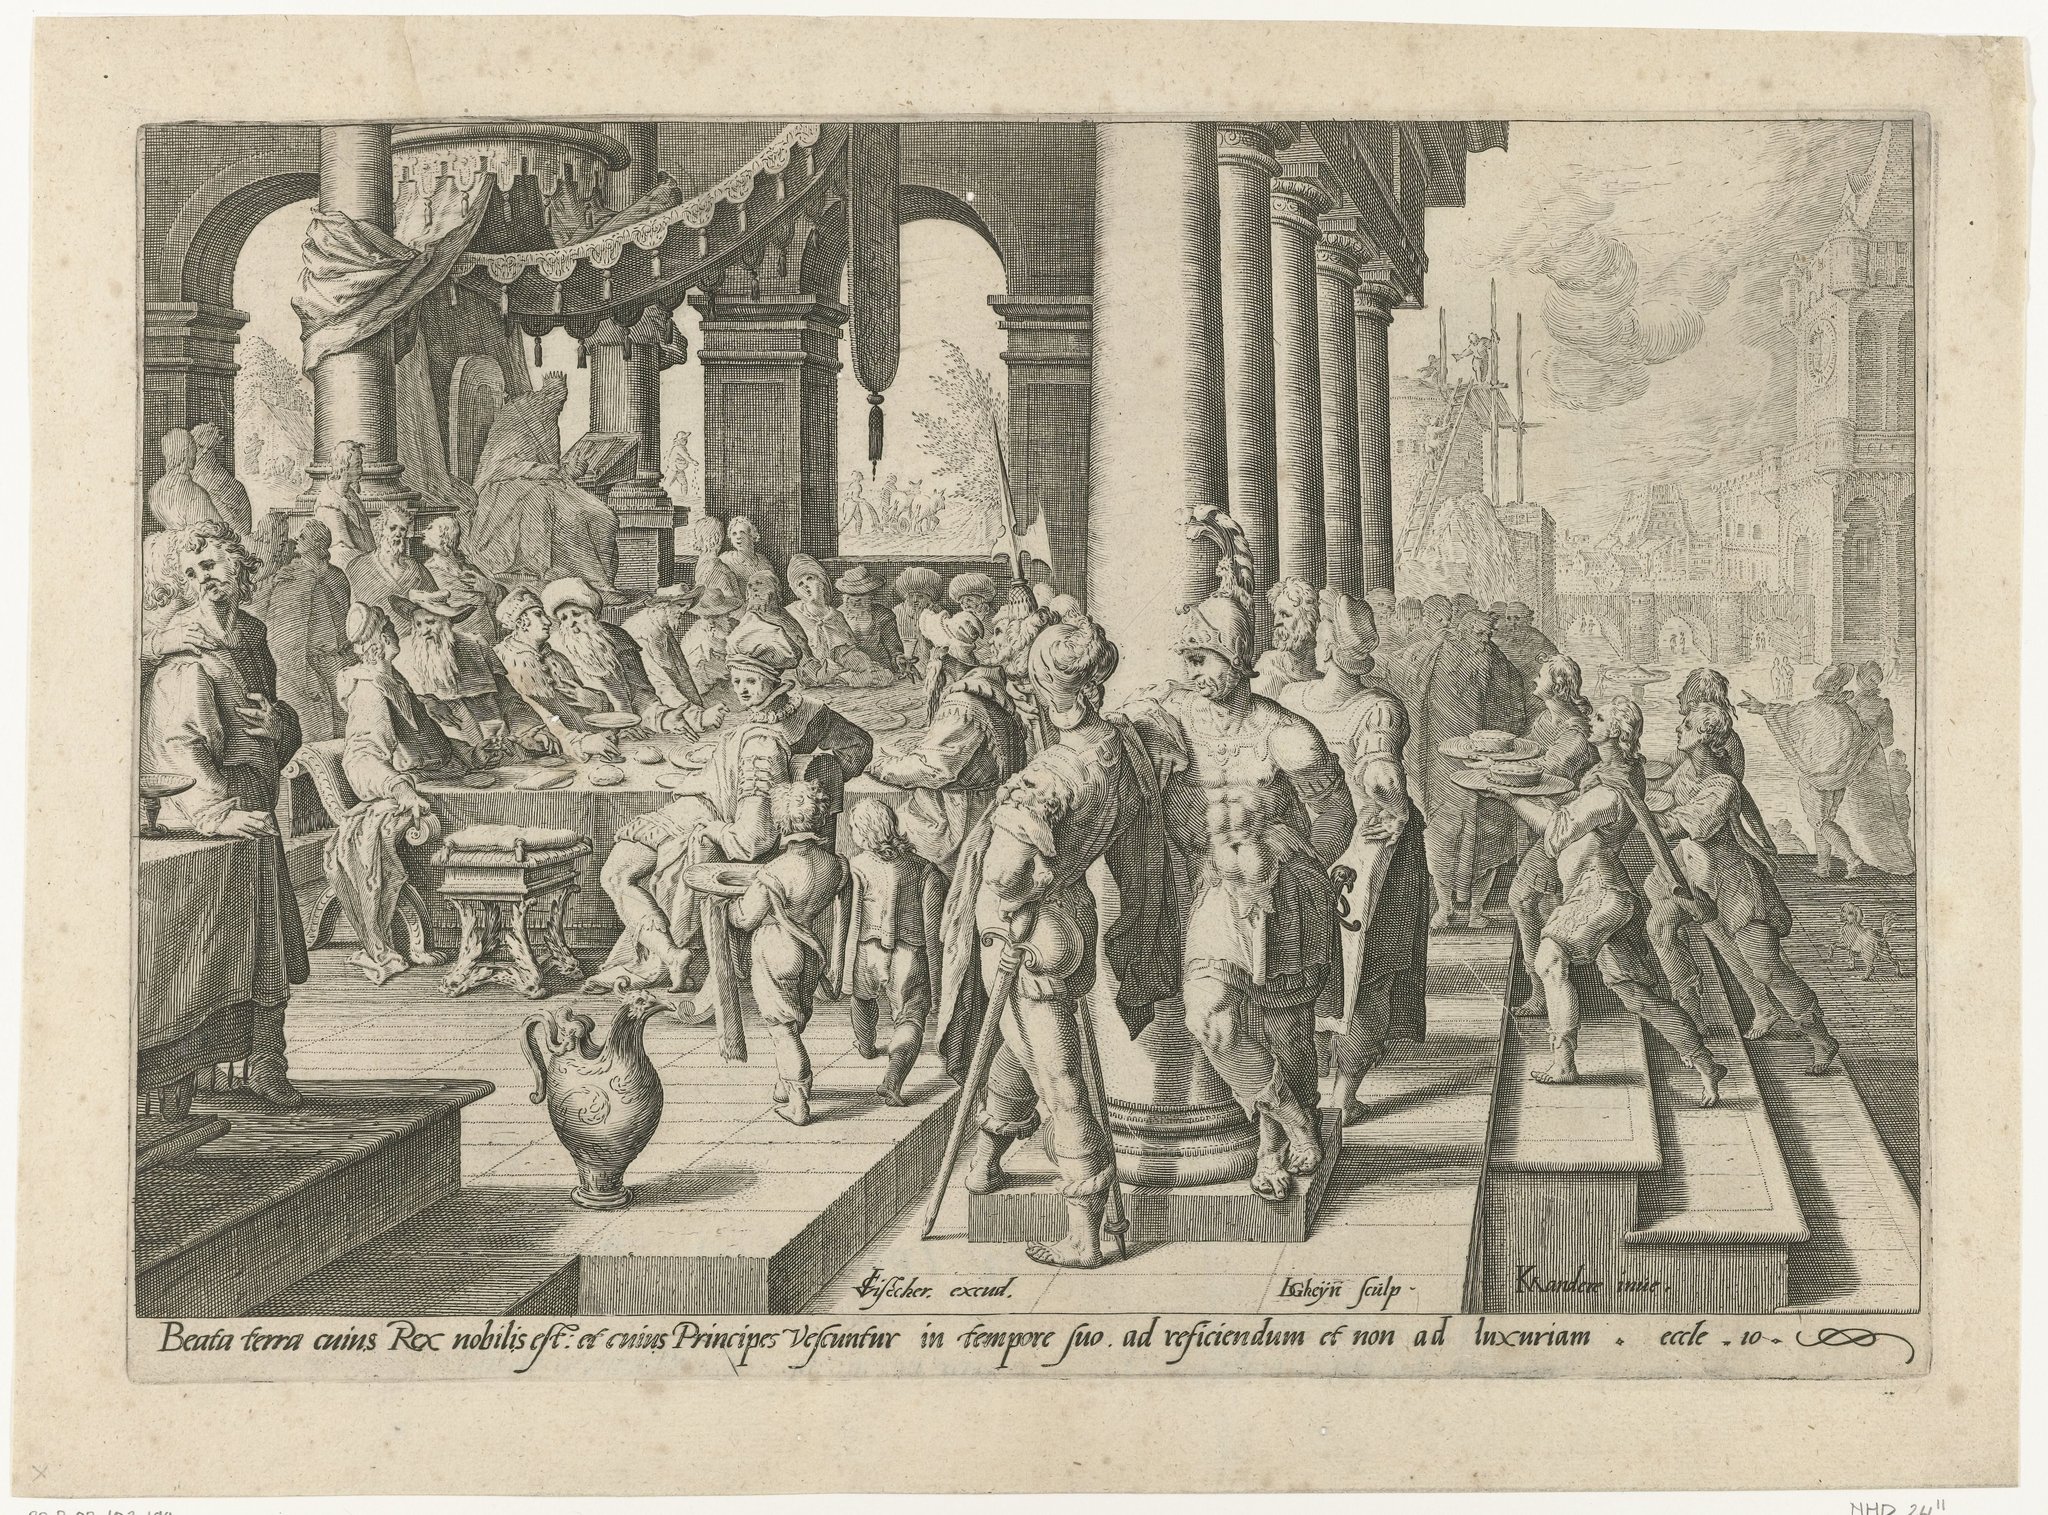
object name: print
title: Het land waarvan de zoon van adellijke afkomst de koning is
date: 1588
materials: paper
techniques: engraving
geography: netherlands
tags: bad government, king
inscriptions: collector's mark: Lugt 2228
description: In een voorportaal zit een man op een troon, een boek op een lessenaar naast zich. Aan zijn voeten gebruikt een groep mensen een de maaltijd. Bedienden komen aangelopen. Op de achtergrond is te zien dat buiten constructieve werkzaamheden gaande zijn: er wordt gezaaid, geploegd en een toren gebouwd of gerepareerd. Onder de voorstelling een regel Latijnse tekst (Eccles. 10:17-18).